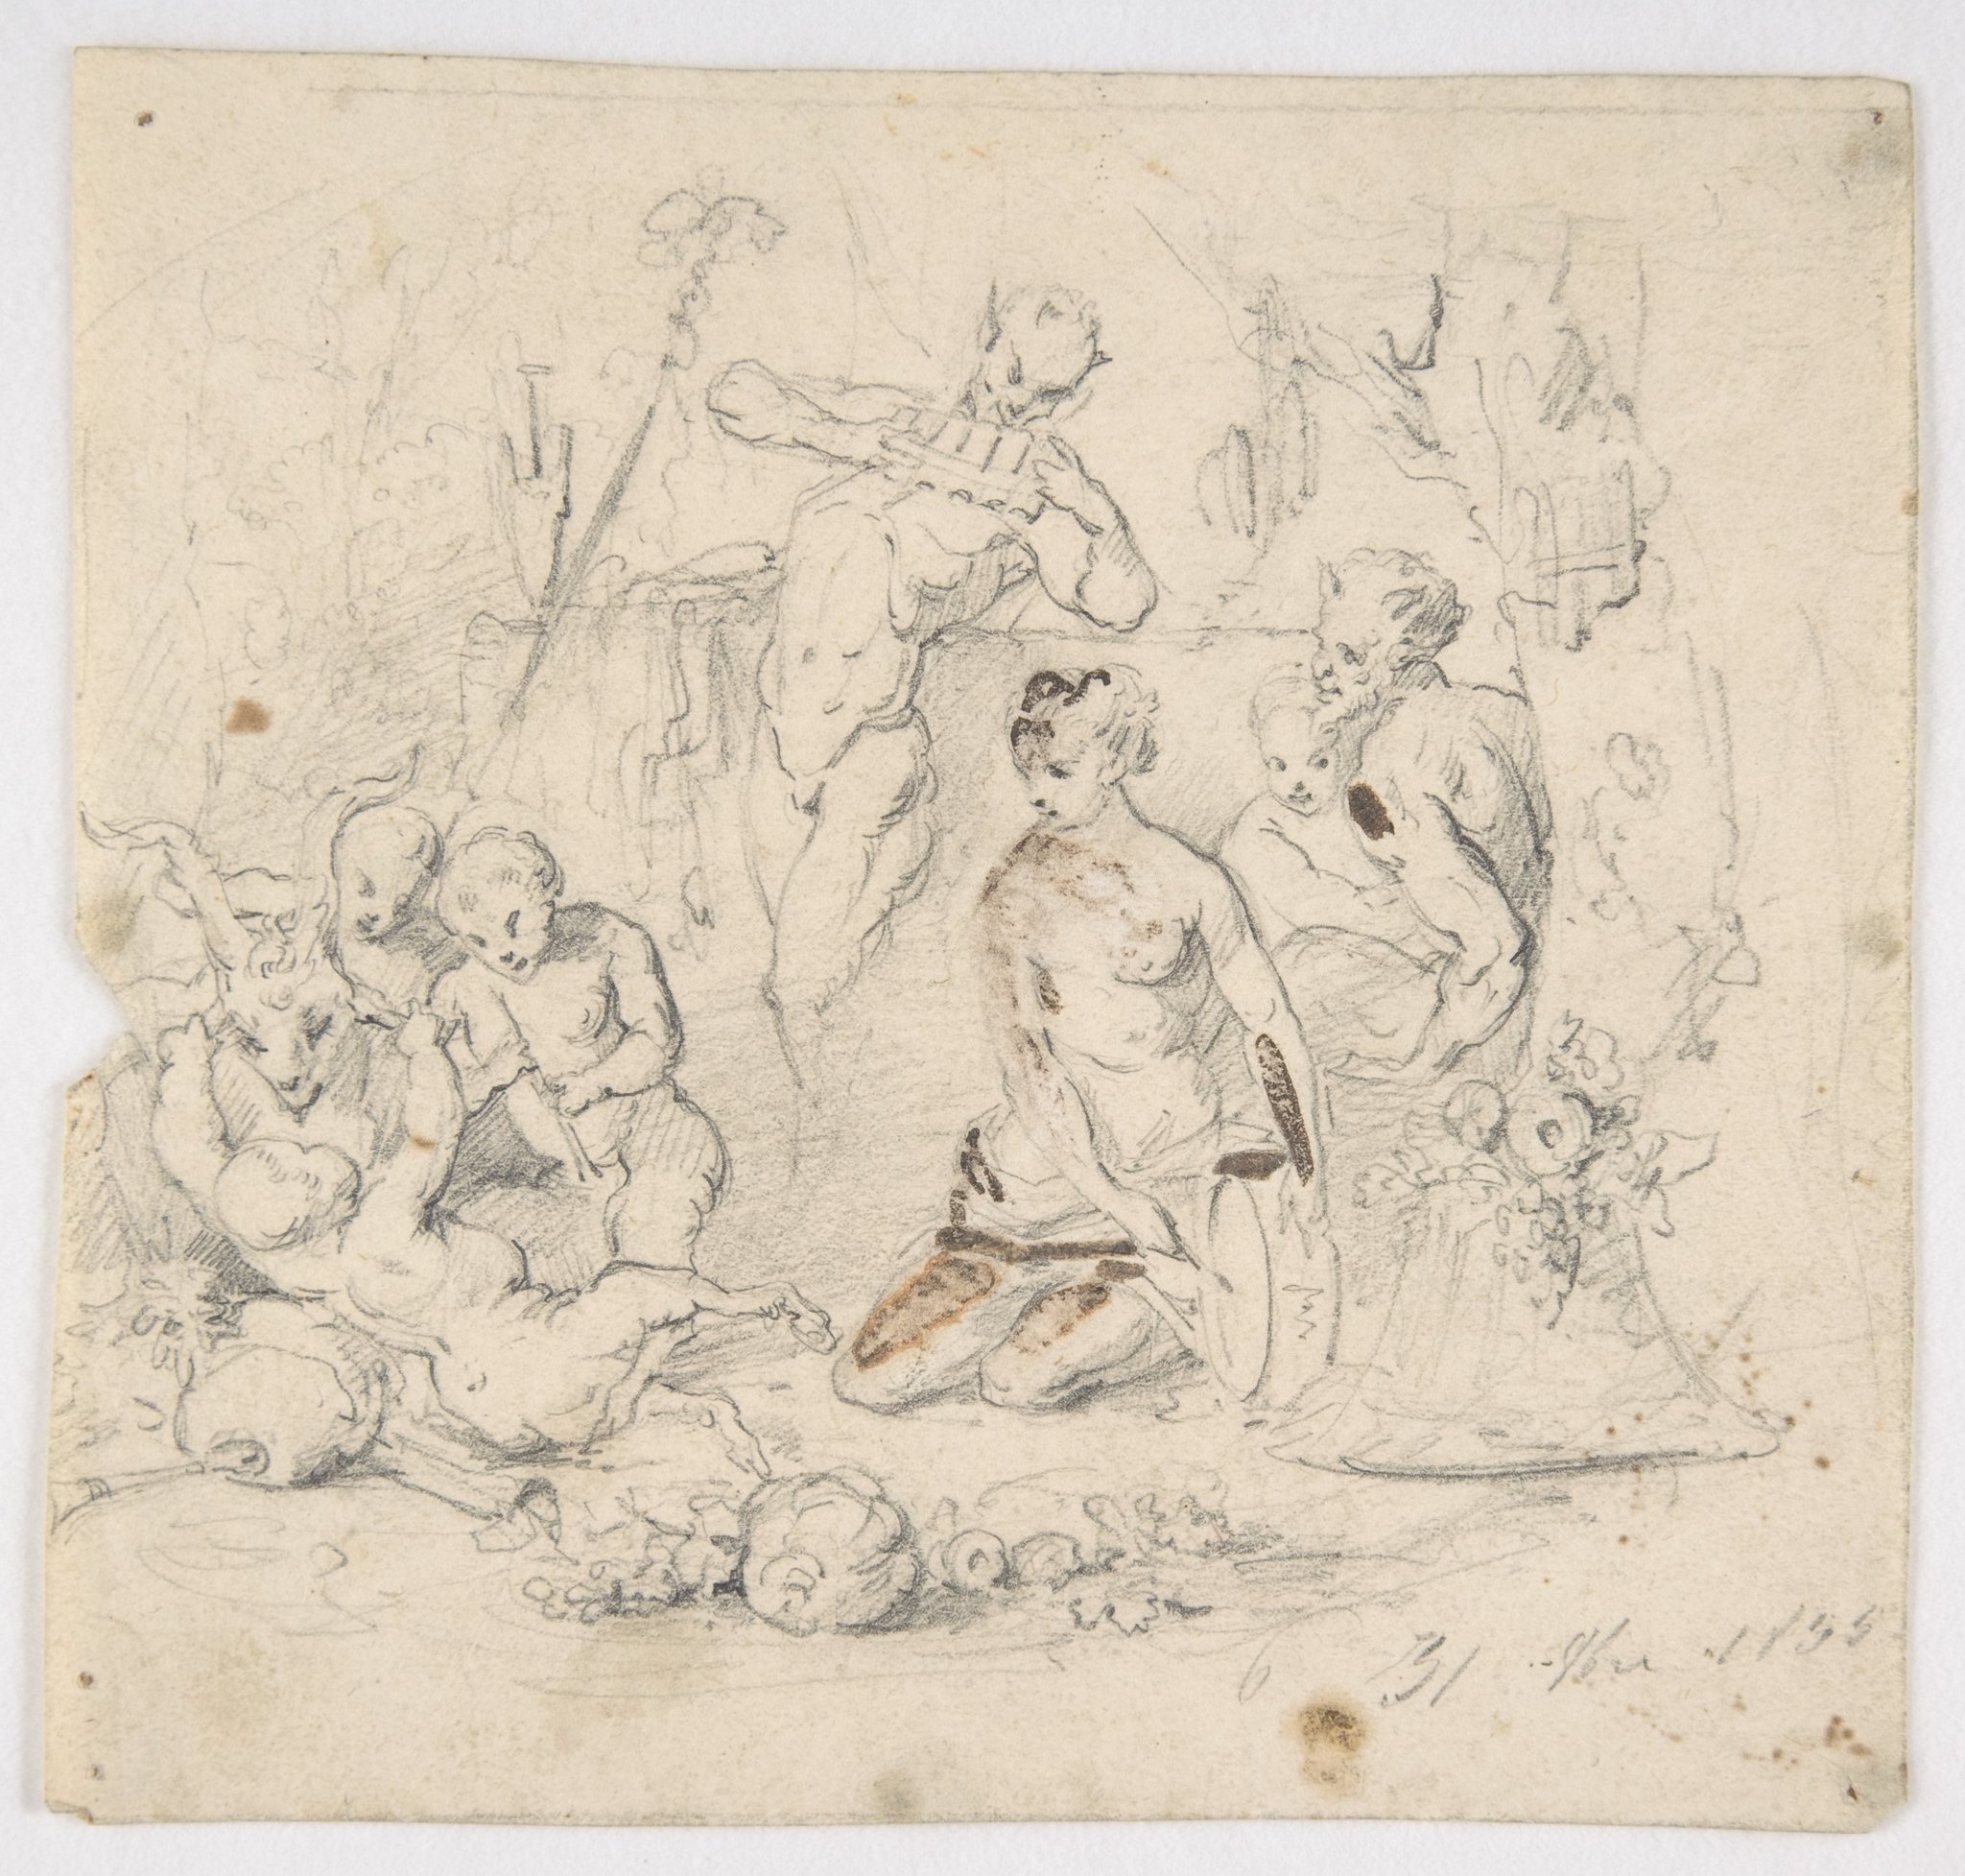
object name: drawing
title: Bacchanal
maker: anonymous, french, 19th century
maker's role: artist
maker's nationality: french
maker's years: 1800-1900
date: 1855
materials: graphite, paper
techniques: heightening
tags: men,women,drinking